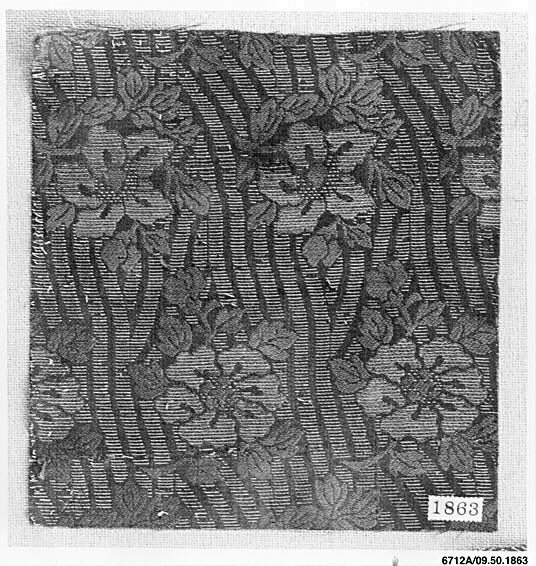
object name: piece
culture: japanese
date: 1701-1800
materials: silk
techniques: brocade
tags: leaves